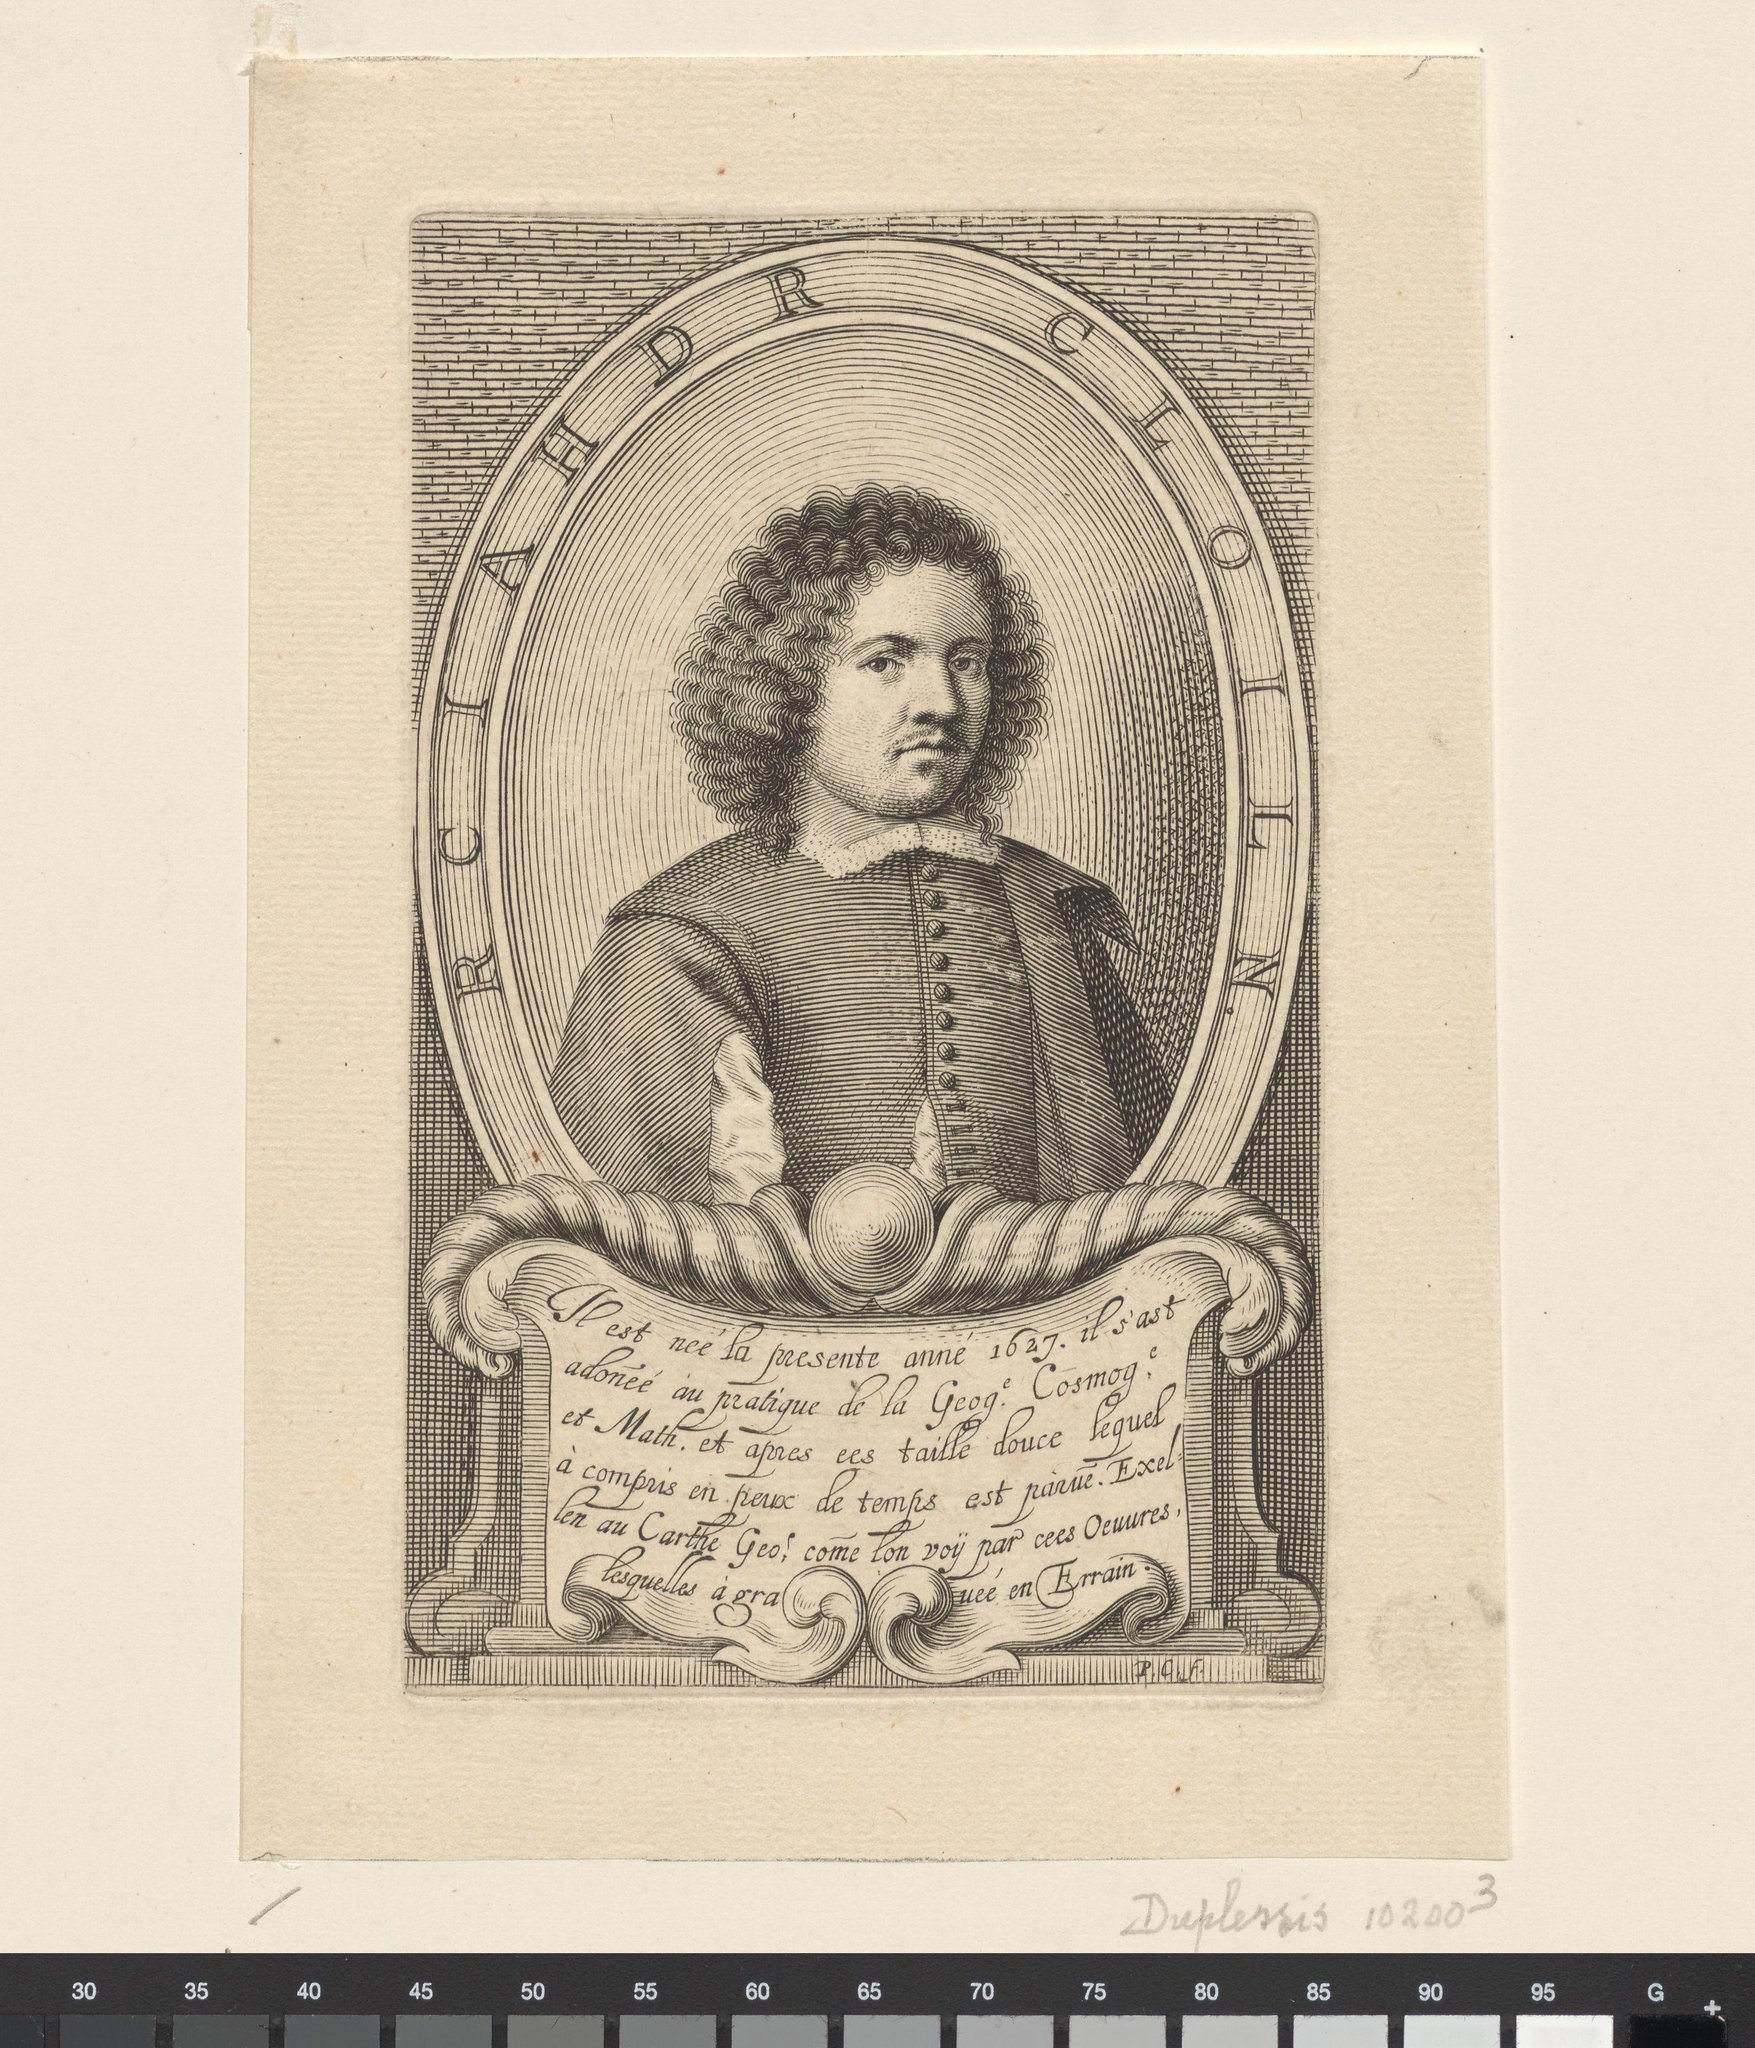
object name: print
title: Portret van Richard Collin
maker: petrus clouwet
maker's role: draughtsman, print maker, publisher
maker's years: 1629-1670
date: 1639-1670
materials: paper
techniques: engraving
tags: brussels, print maker, richard collin, historical persons, portrait, self-portrait of graphic artist